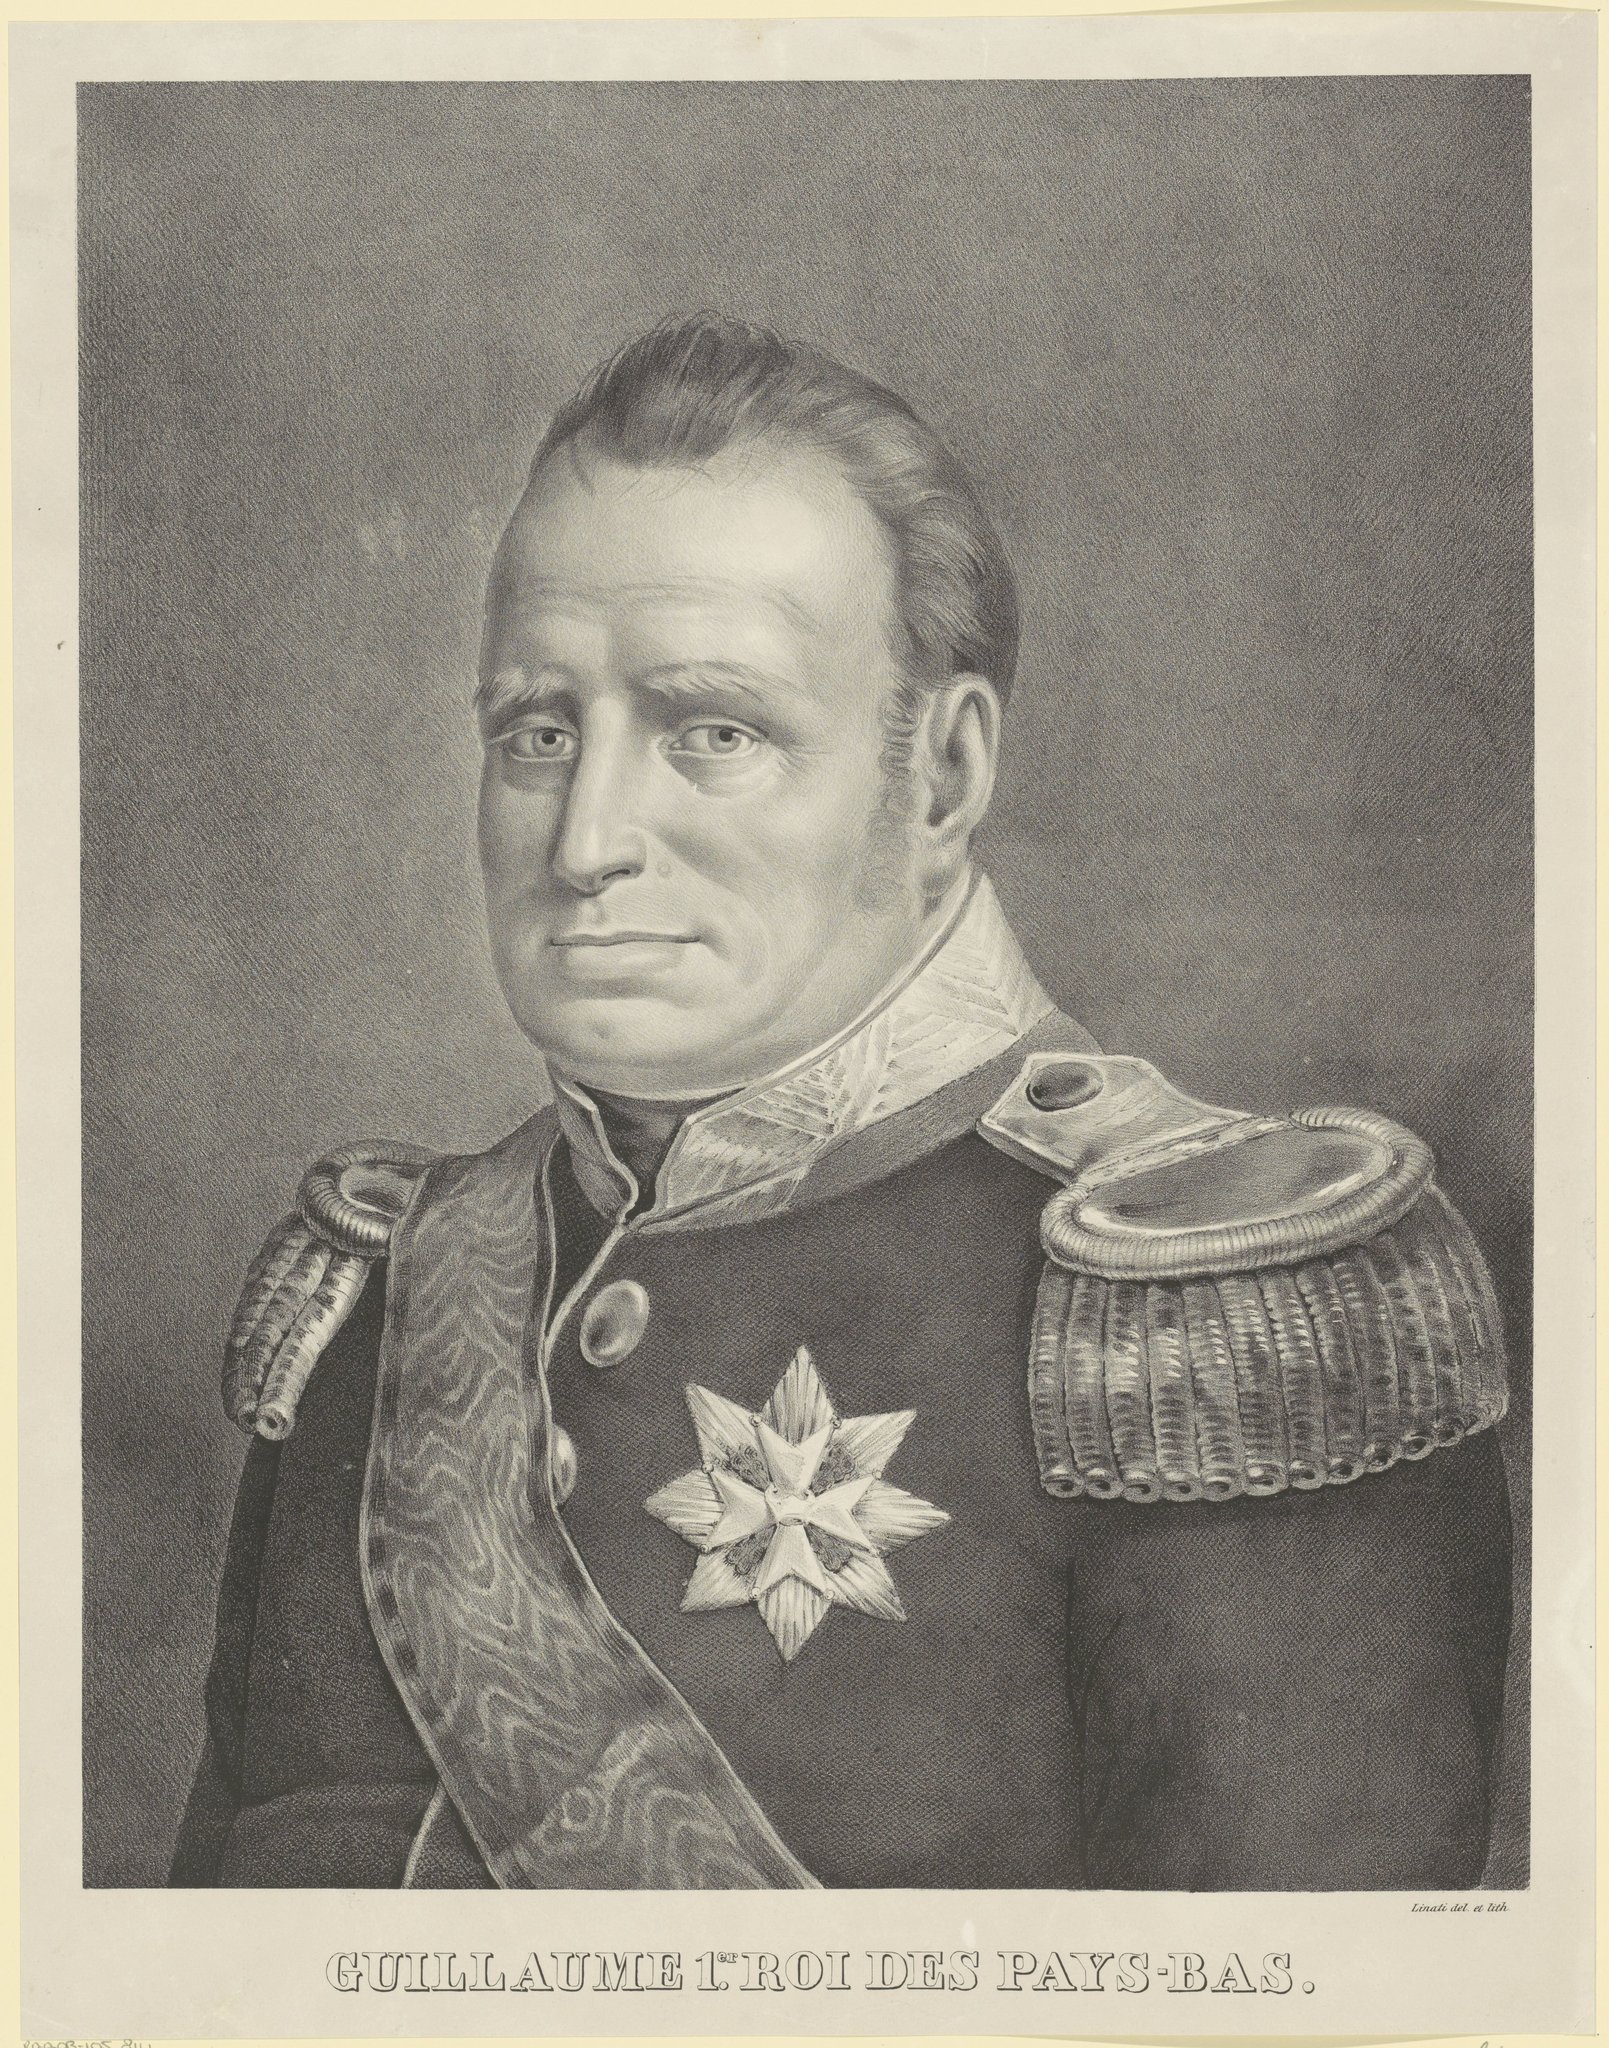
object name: print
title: Portret van Willem I Frederik, koning der Nederlanden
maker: claudio linati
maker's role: print maker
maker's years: 1790-1832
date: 1815-1829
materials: paper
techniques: lithograph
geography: brussels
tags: berlin, william i of the netherlands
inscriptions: collector's mark: Lugt 963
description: De hier vermelde titel verwijst naar de hoogst verkregen titel van de geportretteerde, niet per se naar de titel die de geportretteerde op deze voorstelling draagt.